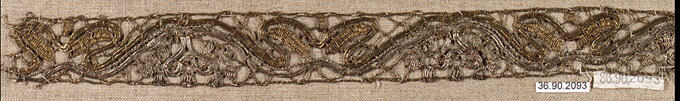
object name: piece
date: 1801-1900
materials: metal thread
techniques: lace